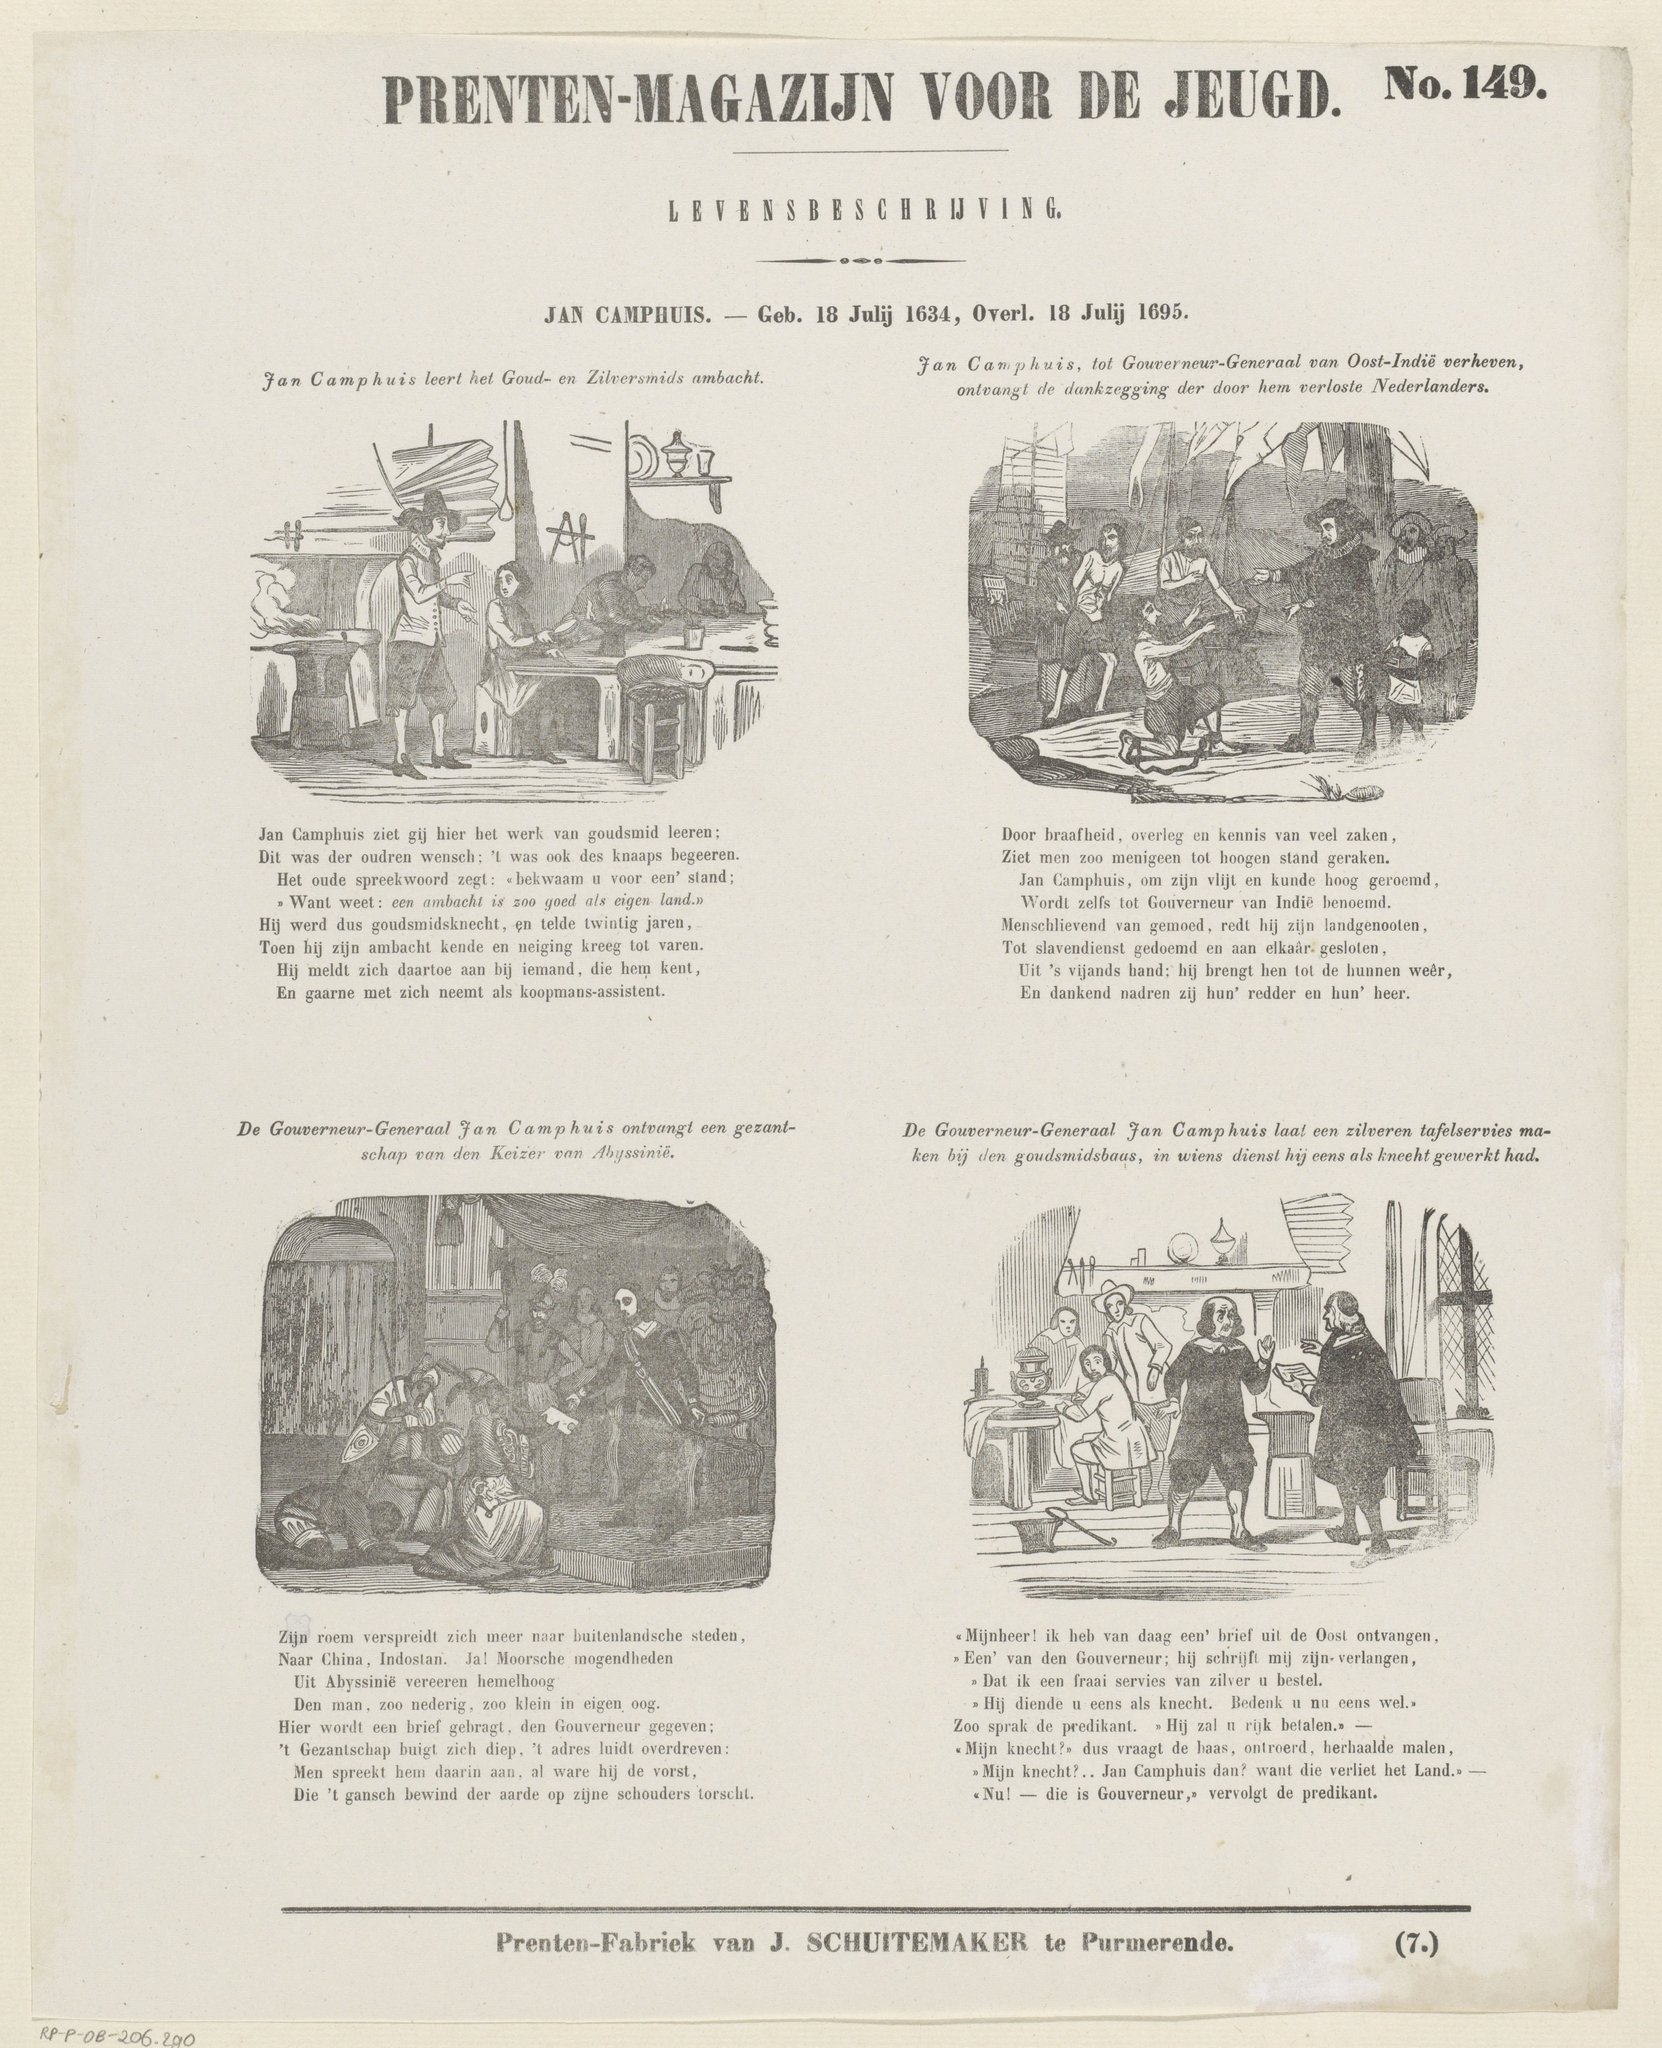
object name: popular print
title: Jan Camphuis. - Geboren 18 Juli 1634, Overl. 18 Juli 1695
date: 1850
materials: paper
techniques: letterpress printing, engraving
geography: purmerend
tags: haarlem, batavia, johannes camphuys, historical persons, jeweller, goldsmith, silversmith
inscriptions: collector's mark: Lugt 2760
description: Na voltooiing van de acht jaargangen van de reeks 'Prenten-magazijn voor de jeugd' in 1850 heeft Jan Schuitemaker al deze prenten heruitgegeven en omgenummerd als nr. 1 t/m 192. De oorspronkelijke jaargang wordt telkens nog vermeld rechtsonder op de prent. Binnen de jaargangen zijn prenten van hetzelfde thema in clusters van vier achter elkaar gezet.